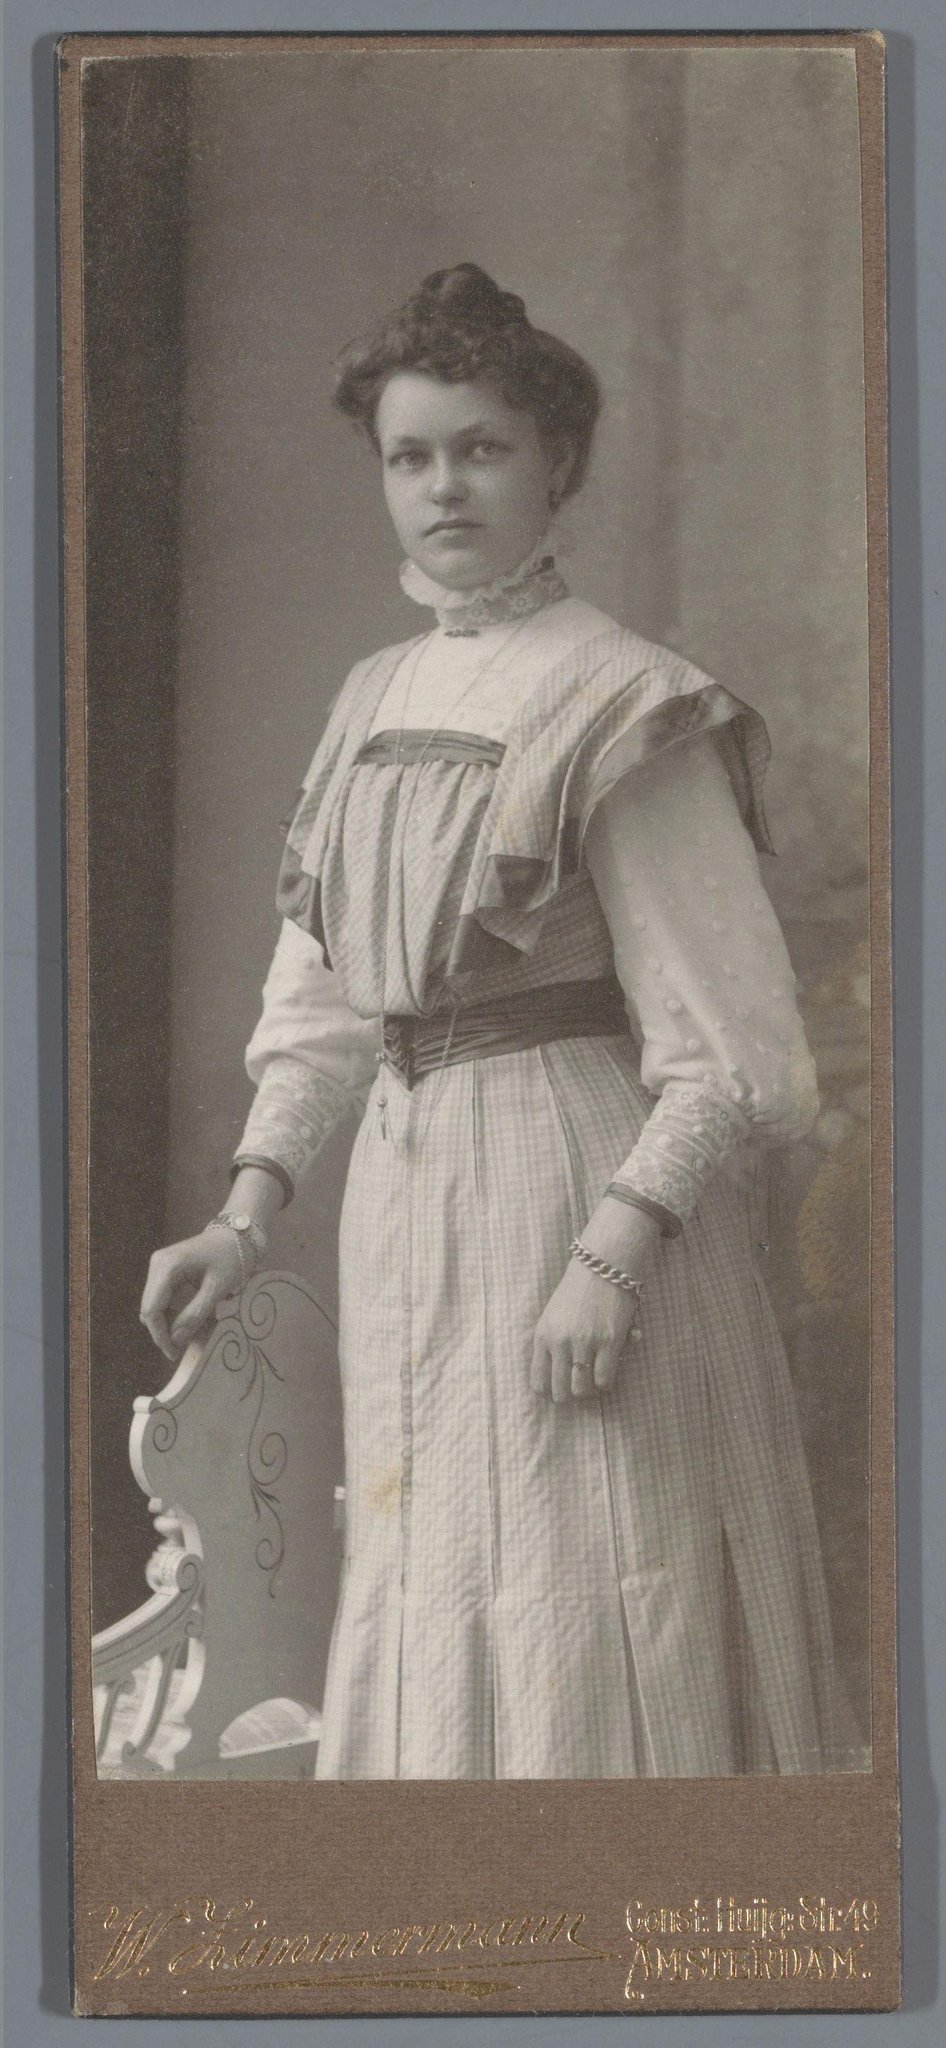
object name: photograph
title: Portret van een onbekende vrouw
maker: guillame maximilien zimmermann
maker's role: fotograaf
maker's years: 1873-1951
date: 1897-1902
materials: paper, cardboard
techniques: gelatin silver print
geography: amsterdam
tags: adult woman, anonymous historical person portrayed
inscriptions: inscription: ‘Vergrootingen naar elk Portret./ De Plaat blijft bewaard./ G. JANSSEN & CO. KÖLN A/R.’, address: ‘Const: Huijg: Str. 49./ b/d. Overtoom./ Amsterdam/ Atelier parterre.’